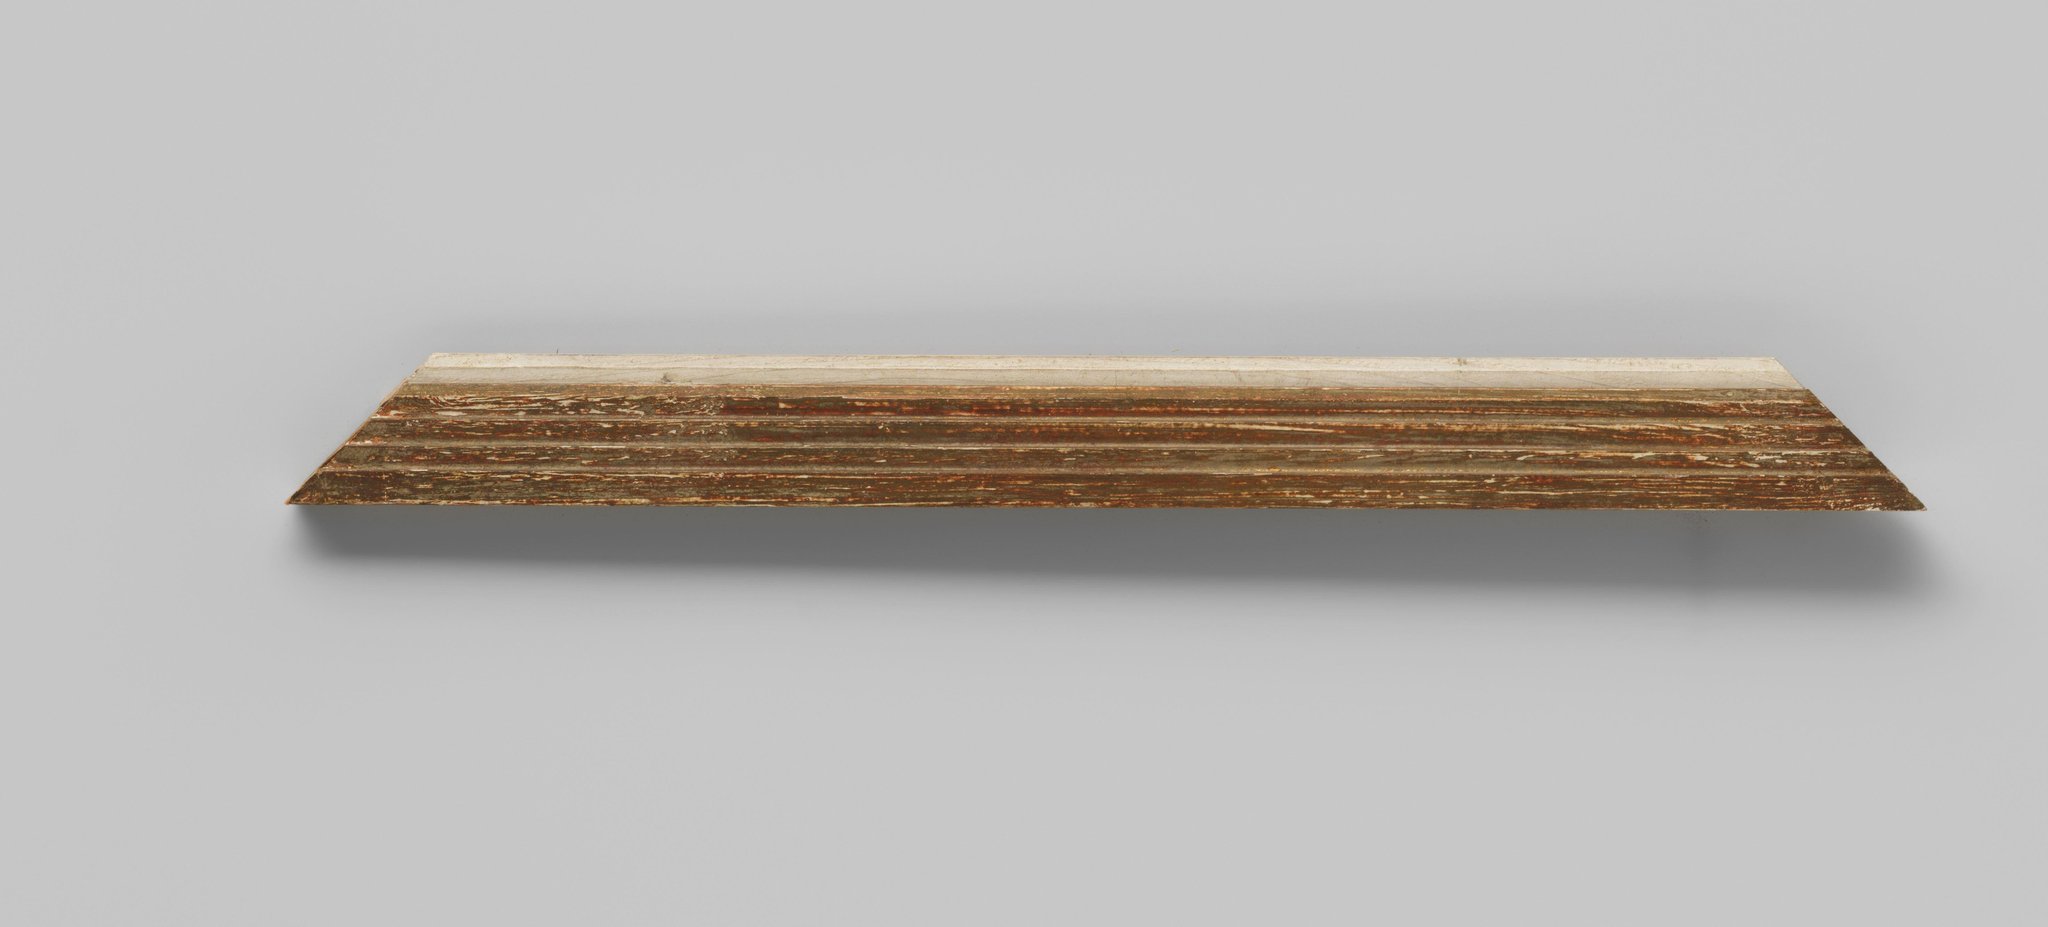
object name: frame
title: Lijstfragment van getrapte profiellijst met witte binnenrand: stijl.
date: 1900-1999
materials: pigment, gesso, paint, wood